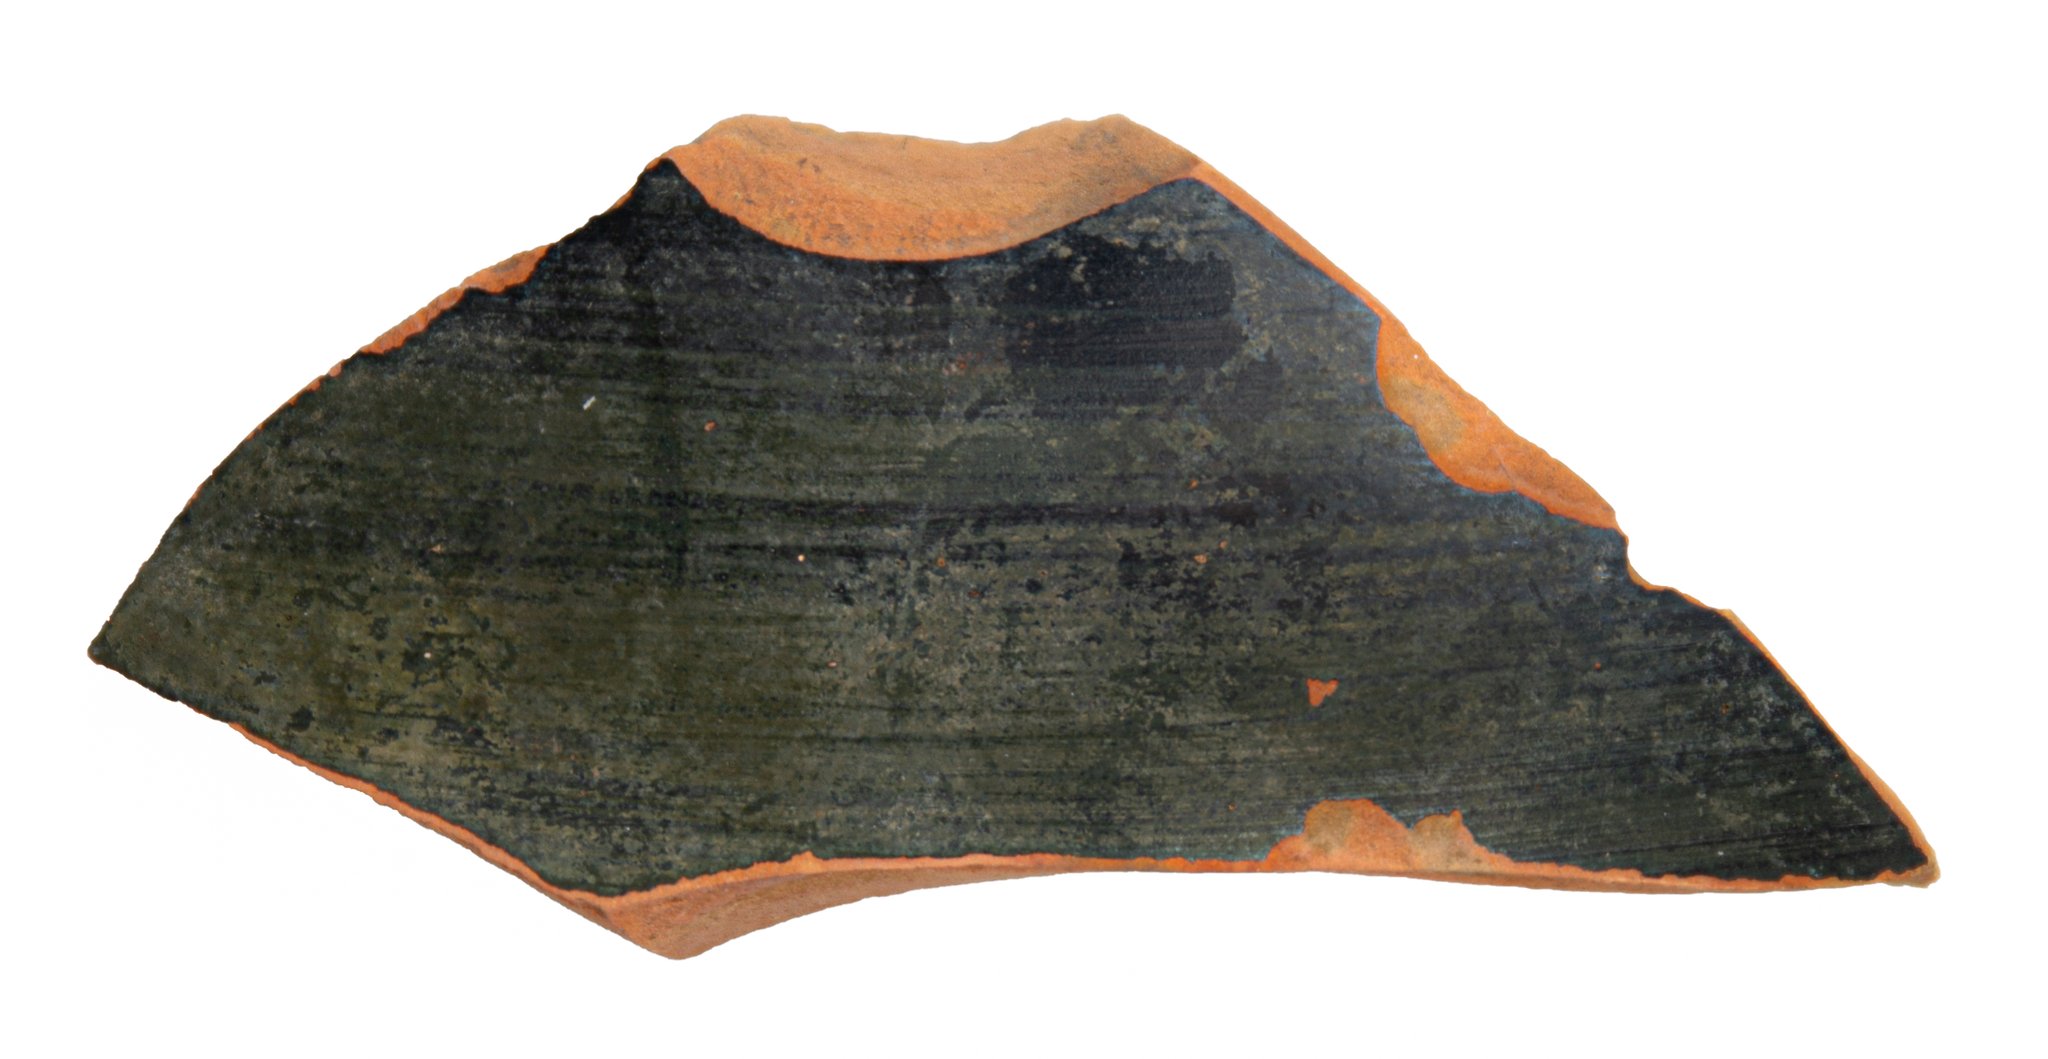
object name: volute krater fragment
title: Volute-krater fragment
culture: greek, south italian, apulian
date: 330-310 BCE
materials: terracotta